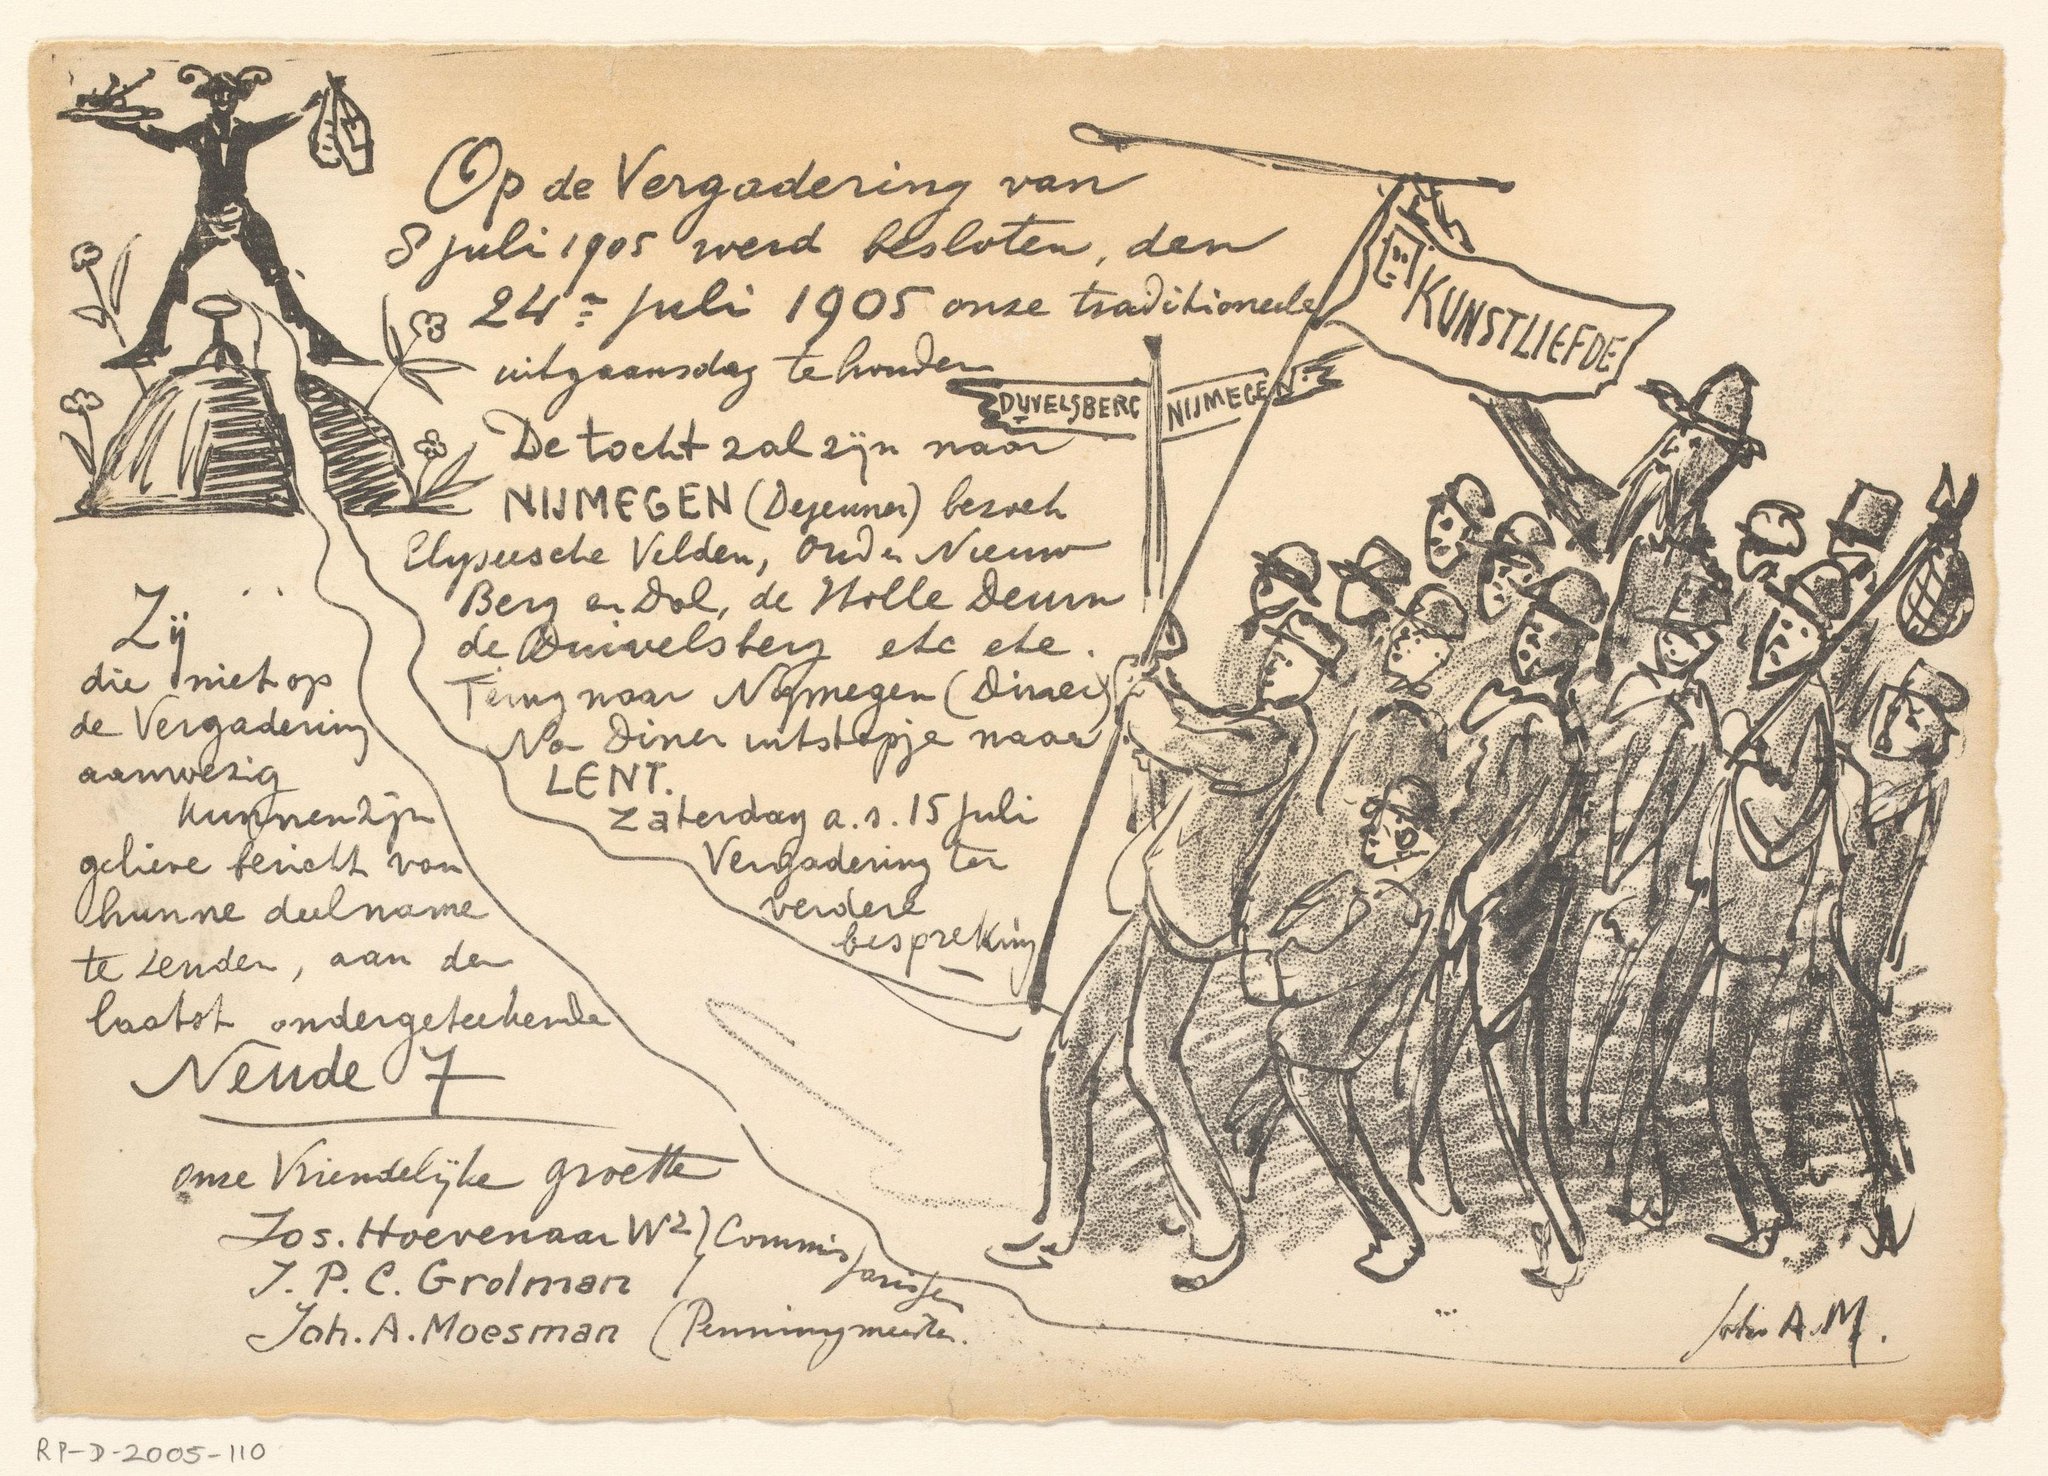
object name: invitation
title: Uitnodiging voor een bijeenkomst op 15 juli van de Schilder- en Teekenkundig Genootschap "Kunstliefde" over de geplande excursie naar Nijmegen op 24 juli 1905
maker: johannes moesman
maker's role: draughtsman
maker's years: 1859-1937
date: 1905-1907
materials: paper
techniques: lithograph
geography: utrecht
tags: criticizing and discussing art, art criticism, circle, club of artists, collecting and exhibiting products of the fine arts, outing, pleasure trip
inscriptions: collector's mark: Lugt 2228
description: Een groep mannen trekt op richting Duivelsberg. Uitnodiging voor een bijeenkomst op 15 juli van de Schilder- en Teekenkundig Genootschap "Kunstliefde" over de geplande excursie naar Nijmegen en de Duivelsberg in Berg en Dal op 24 juli 1905.